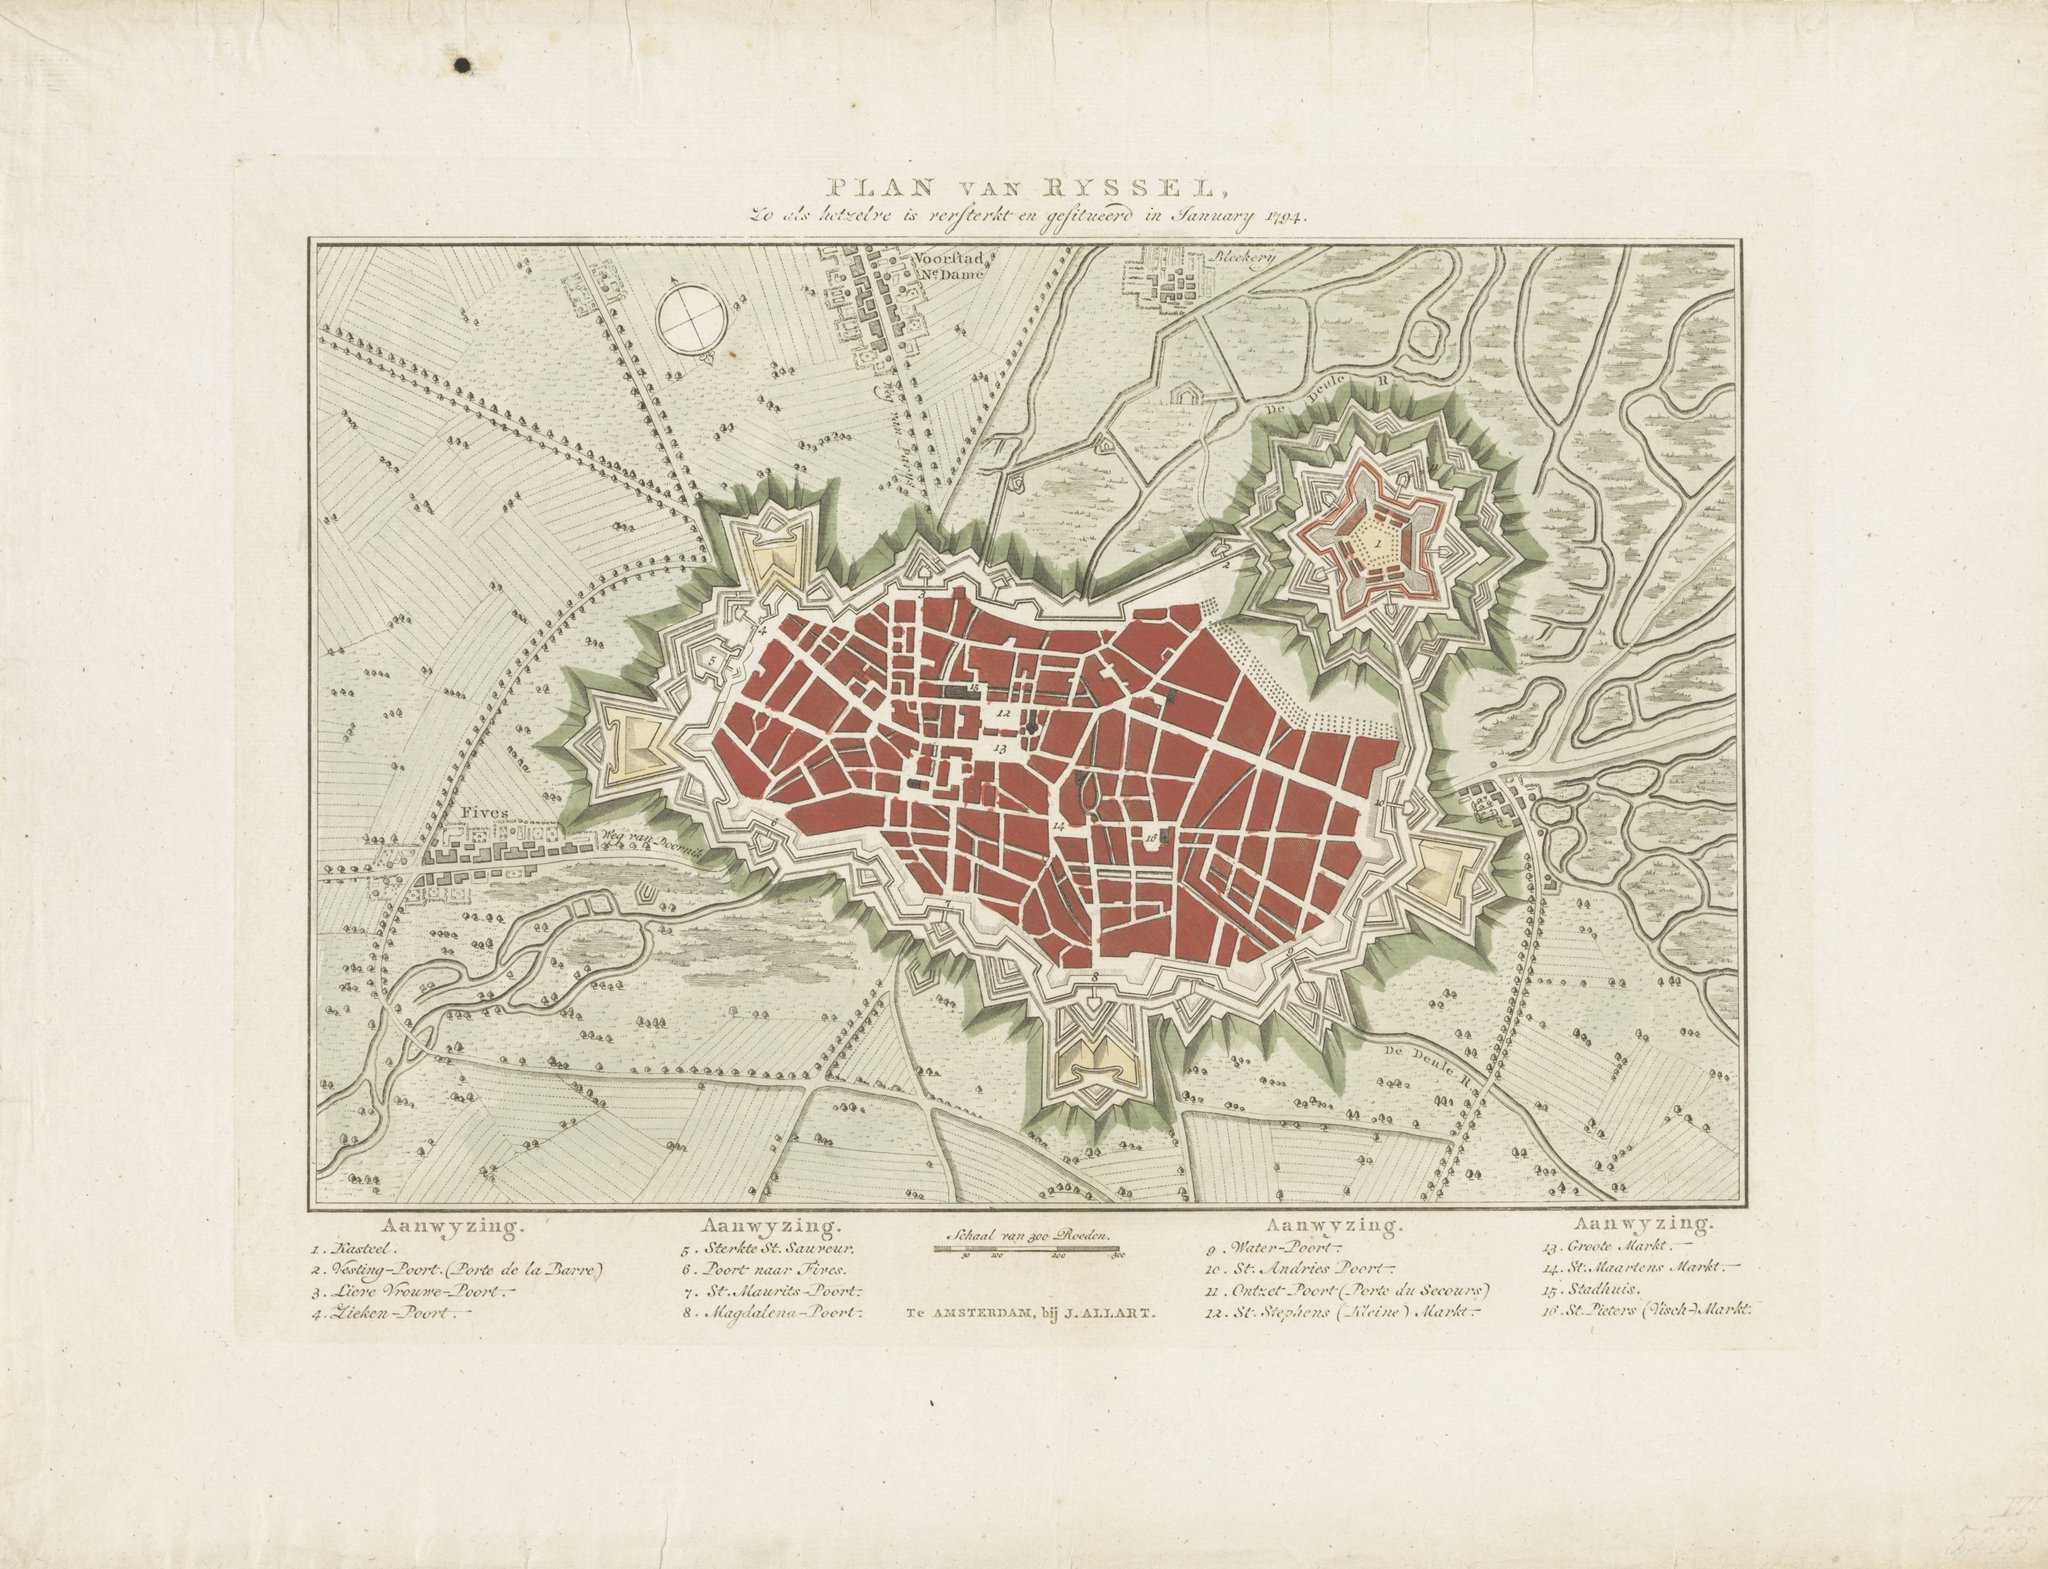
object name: print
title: Plattegronden van versterkte steden in de Oostenrijkse Nederlanden in 1794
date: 1794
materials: paper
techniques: engraving, etching, hand coloring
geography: northern netherlands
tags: fortified city, maps of cities, lille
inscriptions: collector's mark: Lugt 2228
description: Plattegrond van de versterkingen om de stad Lille (Rijssel), in januari 1794. In het onderschrift de legenda 1-16. Onderdeel van een serie van zeven bladen met plattegronden van versterkte steden in de Oostenrijkse Nederlanden ten tijde van de tweede Franse inval onder generaal Pichu in 1794.